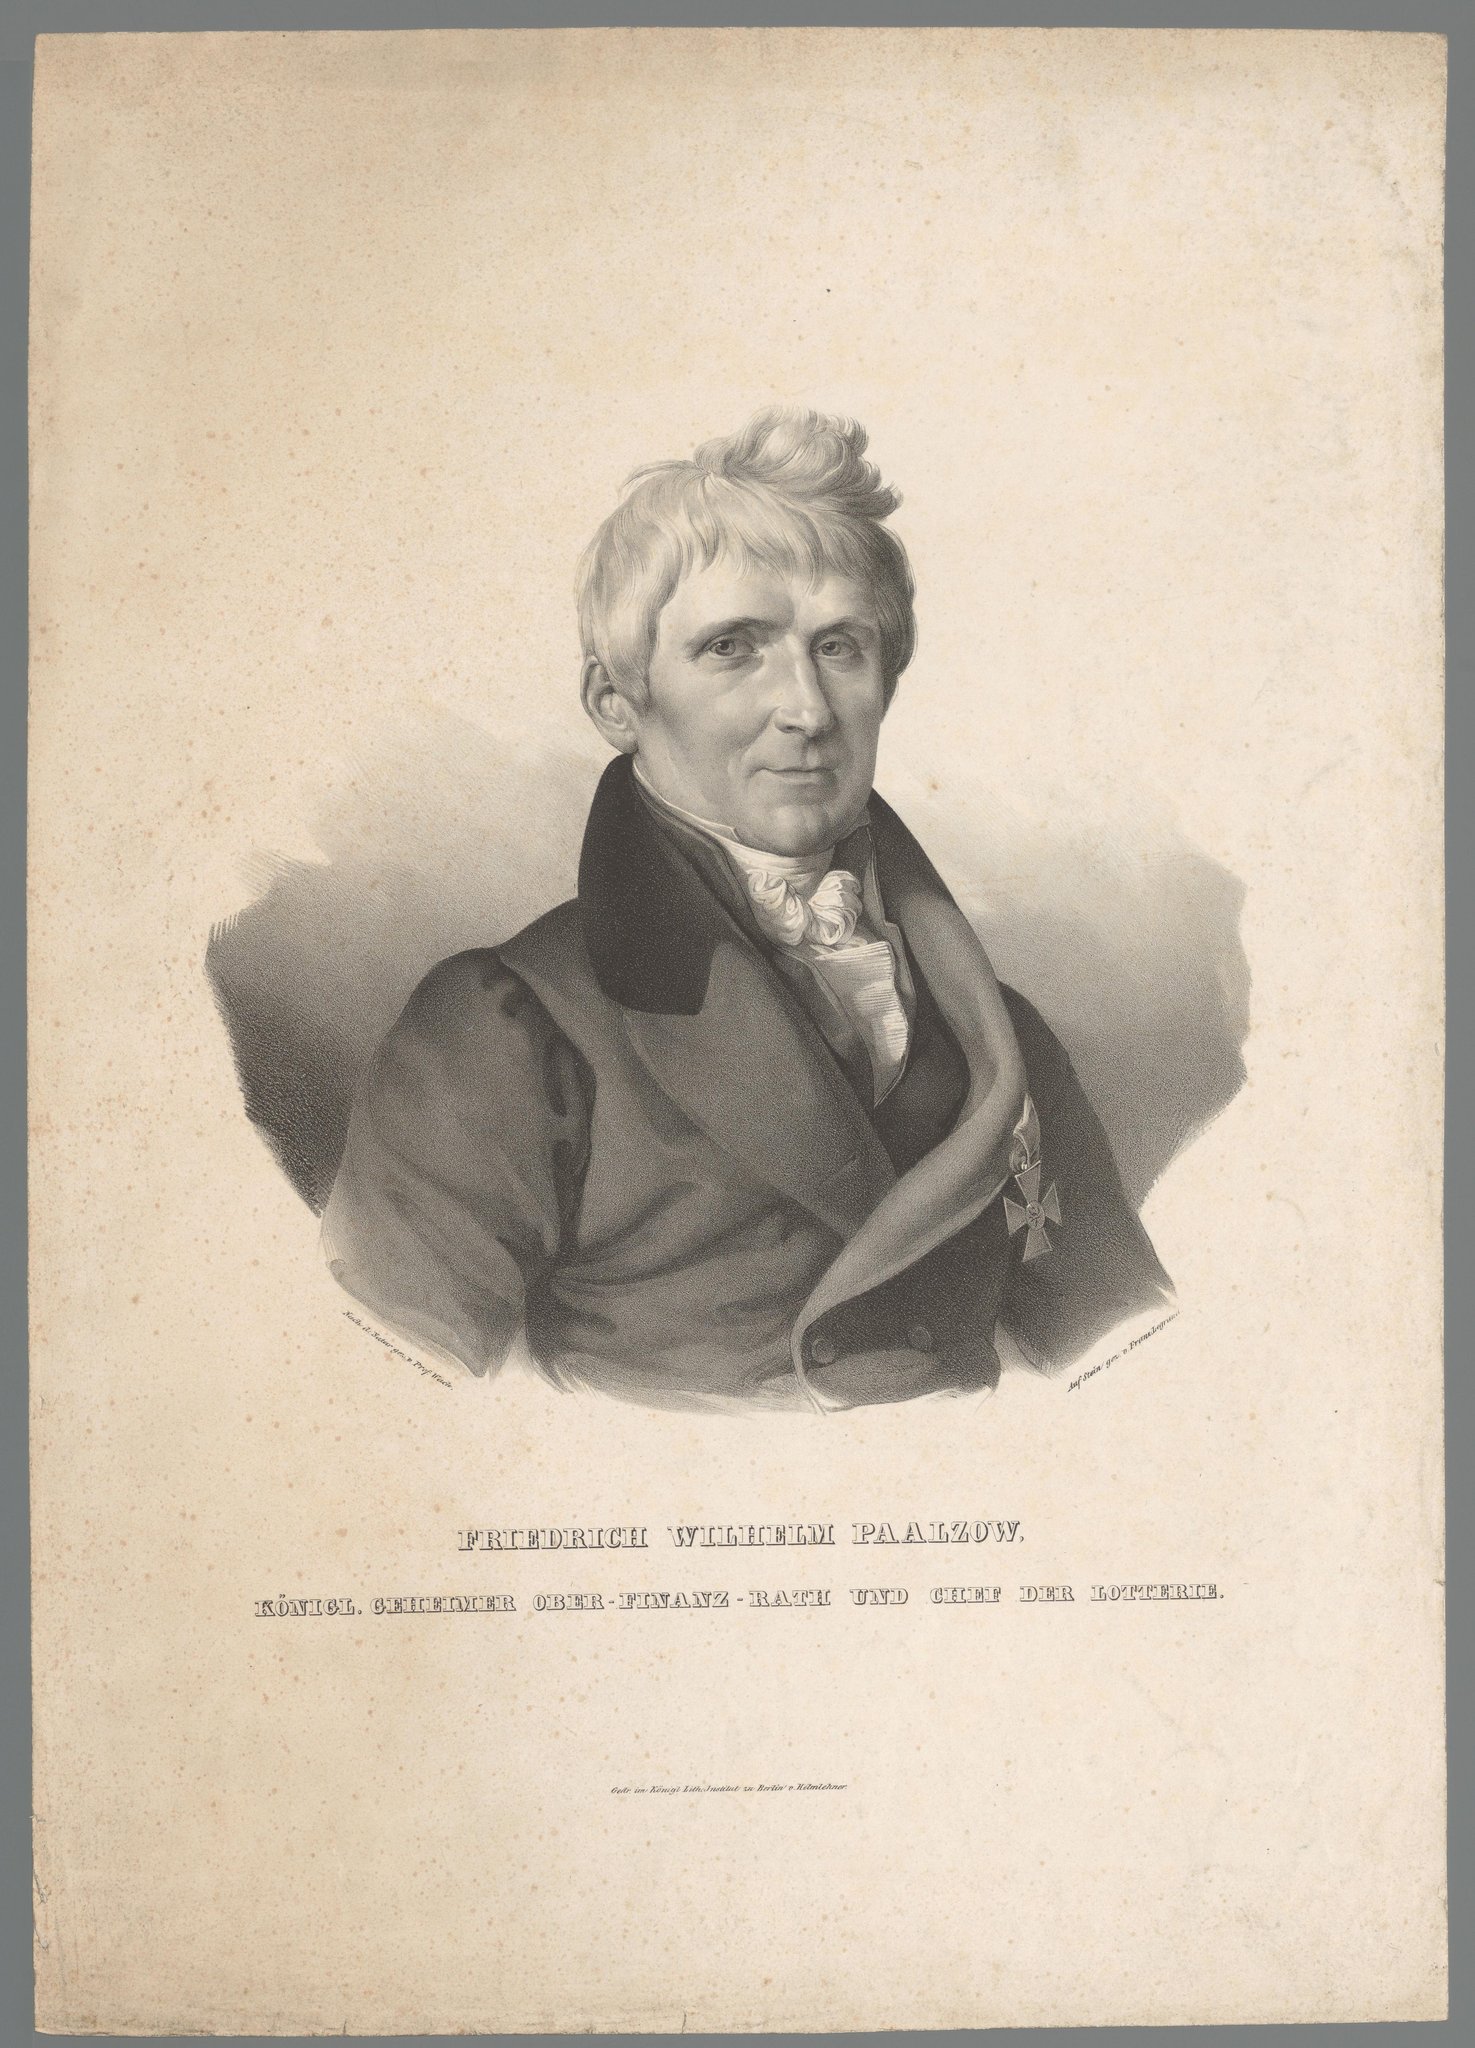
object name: print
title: Portret van Friedrich Wilhelm Paalzow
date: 1817-1835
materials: paper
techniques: lithograph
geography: berlin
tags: historical persons not known by name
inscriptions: collector's mark: Lugt 2228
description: Portret van een verder onbekende man met de naam Friedrich Wilhelm Paalzow of Palzow, politicus en chef van loterijen.